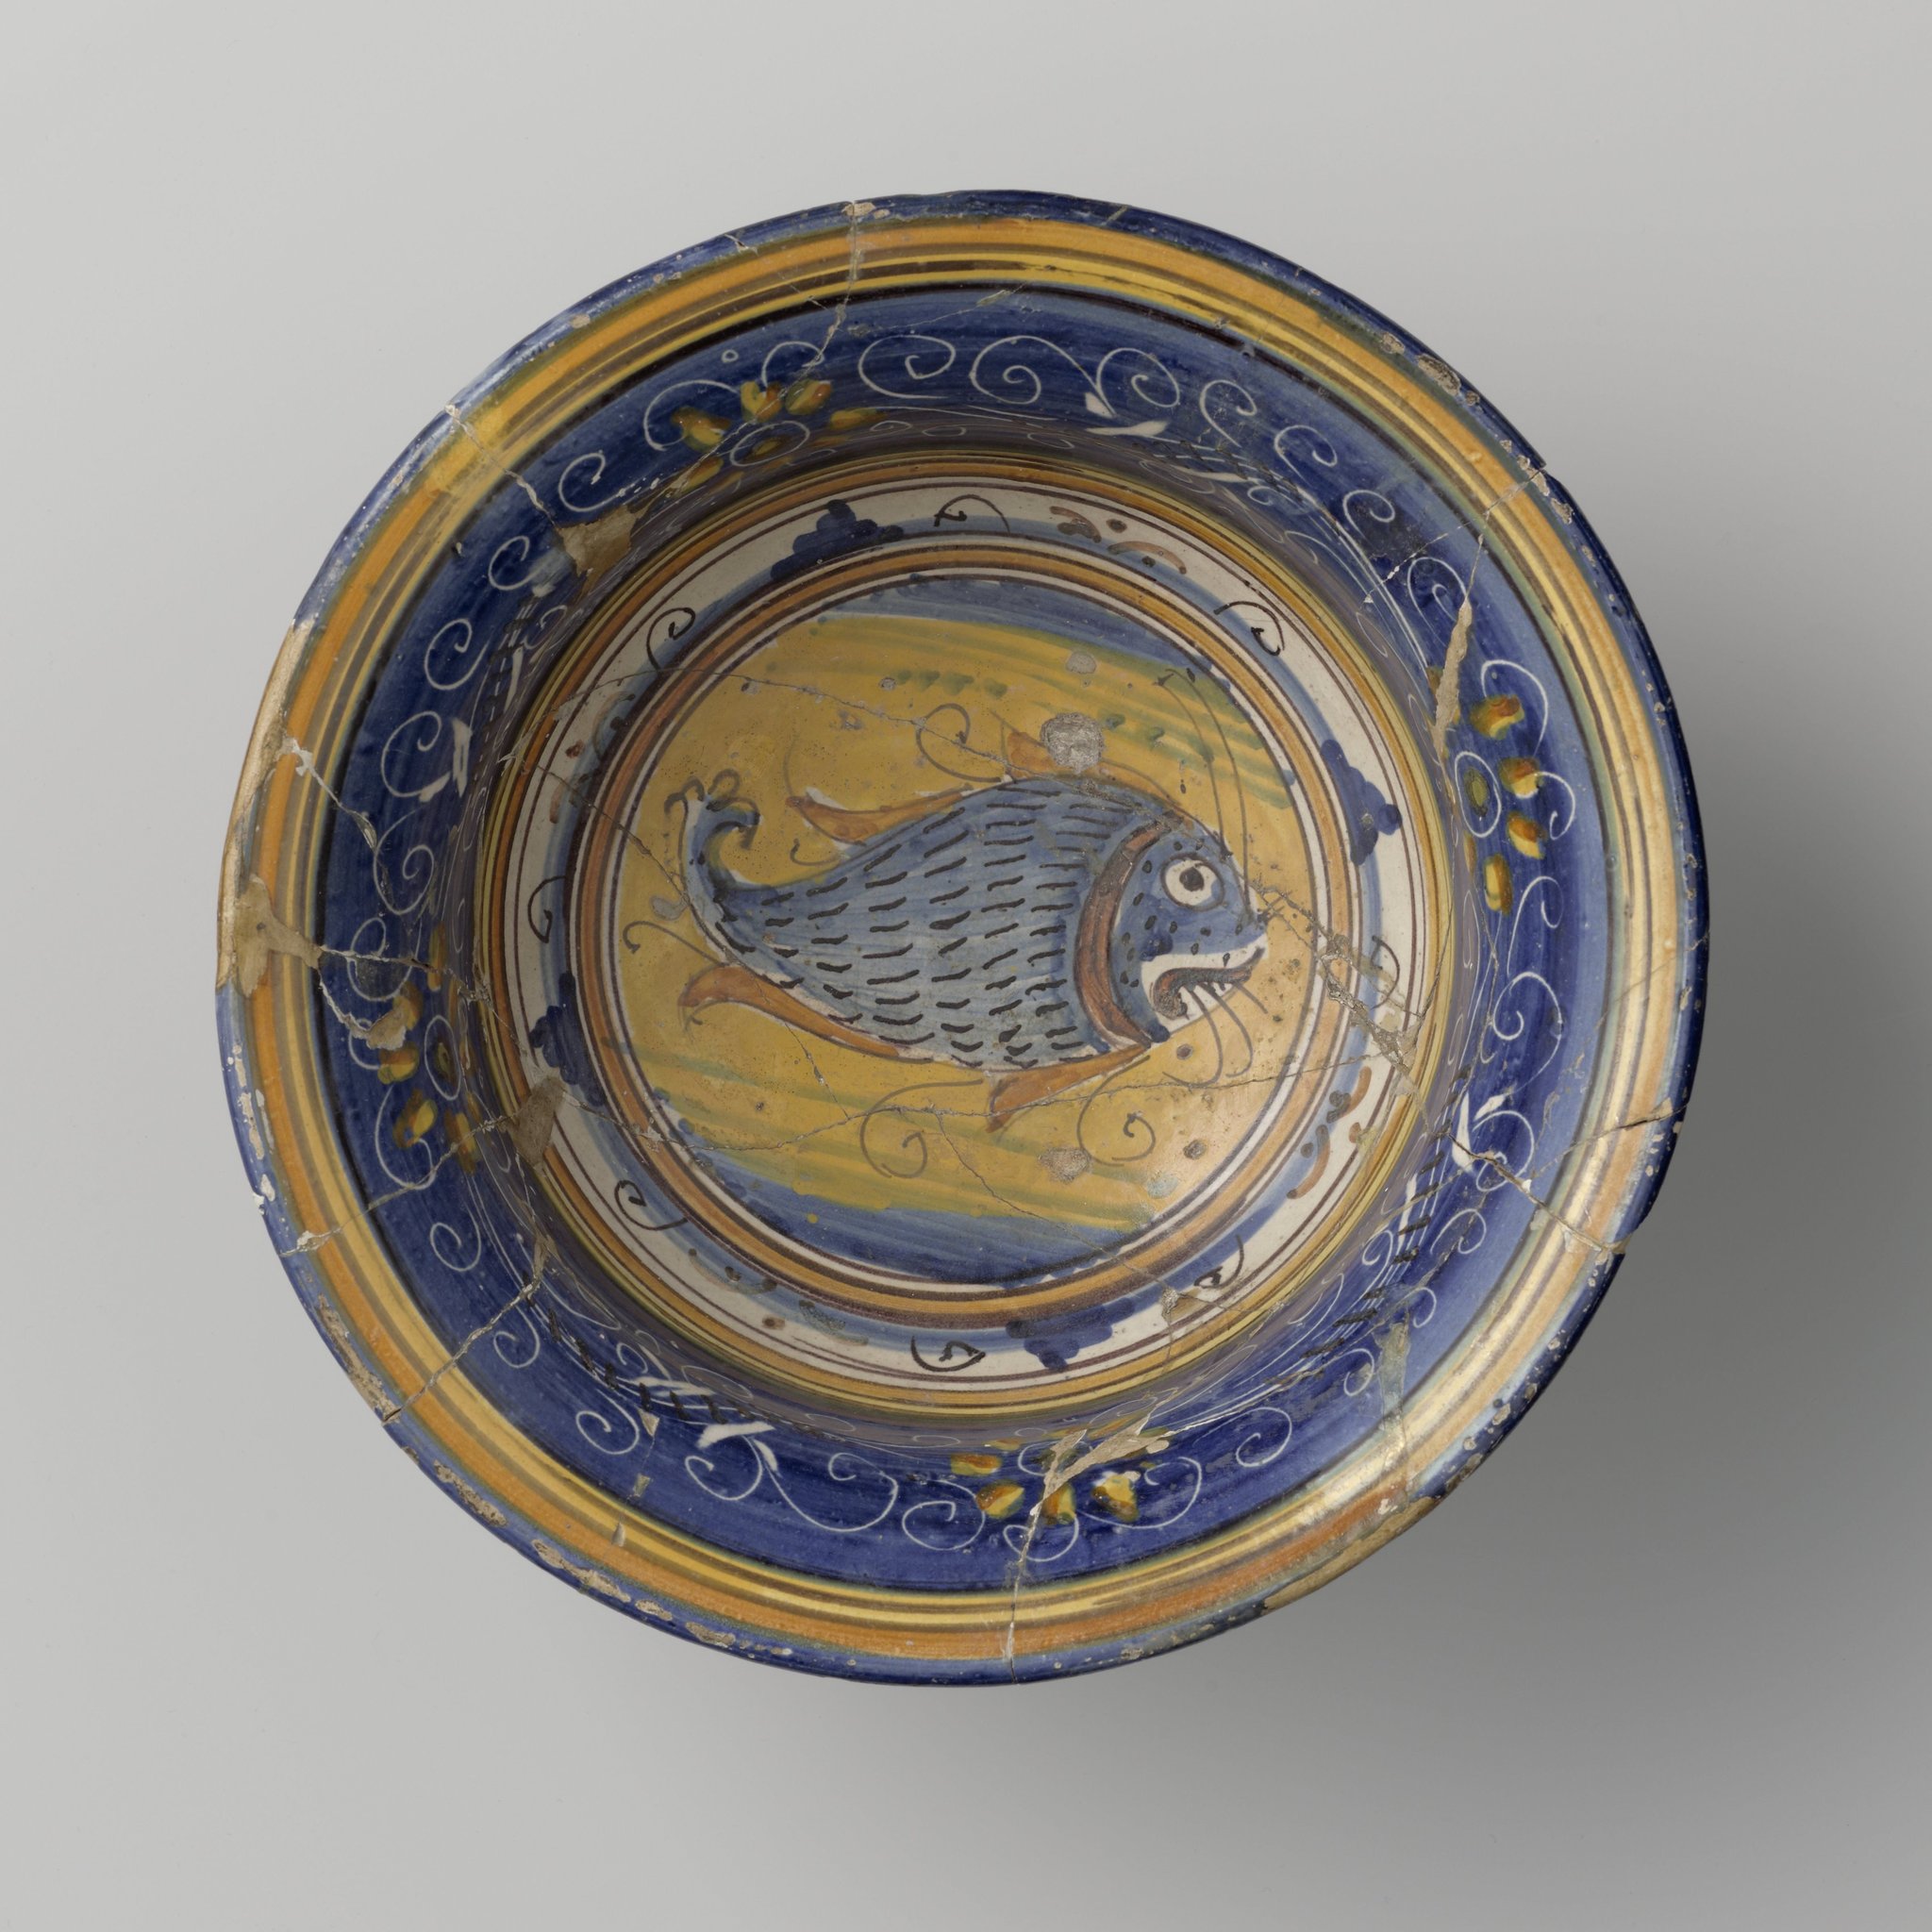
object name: bowl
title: Kom van veelkleurig beschilderde majolica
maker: Anonymous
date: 1540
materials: earthenware, glaze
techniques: maiolica, painted, polychromy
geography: montelupo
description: Klokvormige kom van veelkleurig beschilderde majolica. De kom staat op een voet. Op de bodem aan de binnenkant is een vis geschilderd en op de wand een brede blauwe band waarop in geel en oranje bloemenranken. Op de buitenwand is eenzelfde band geschilderd.